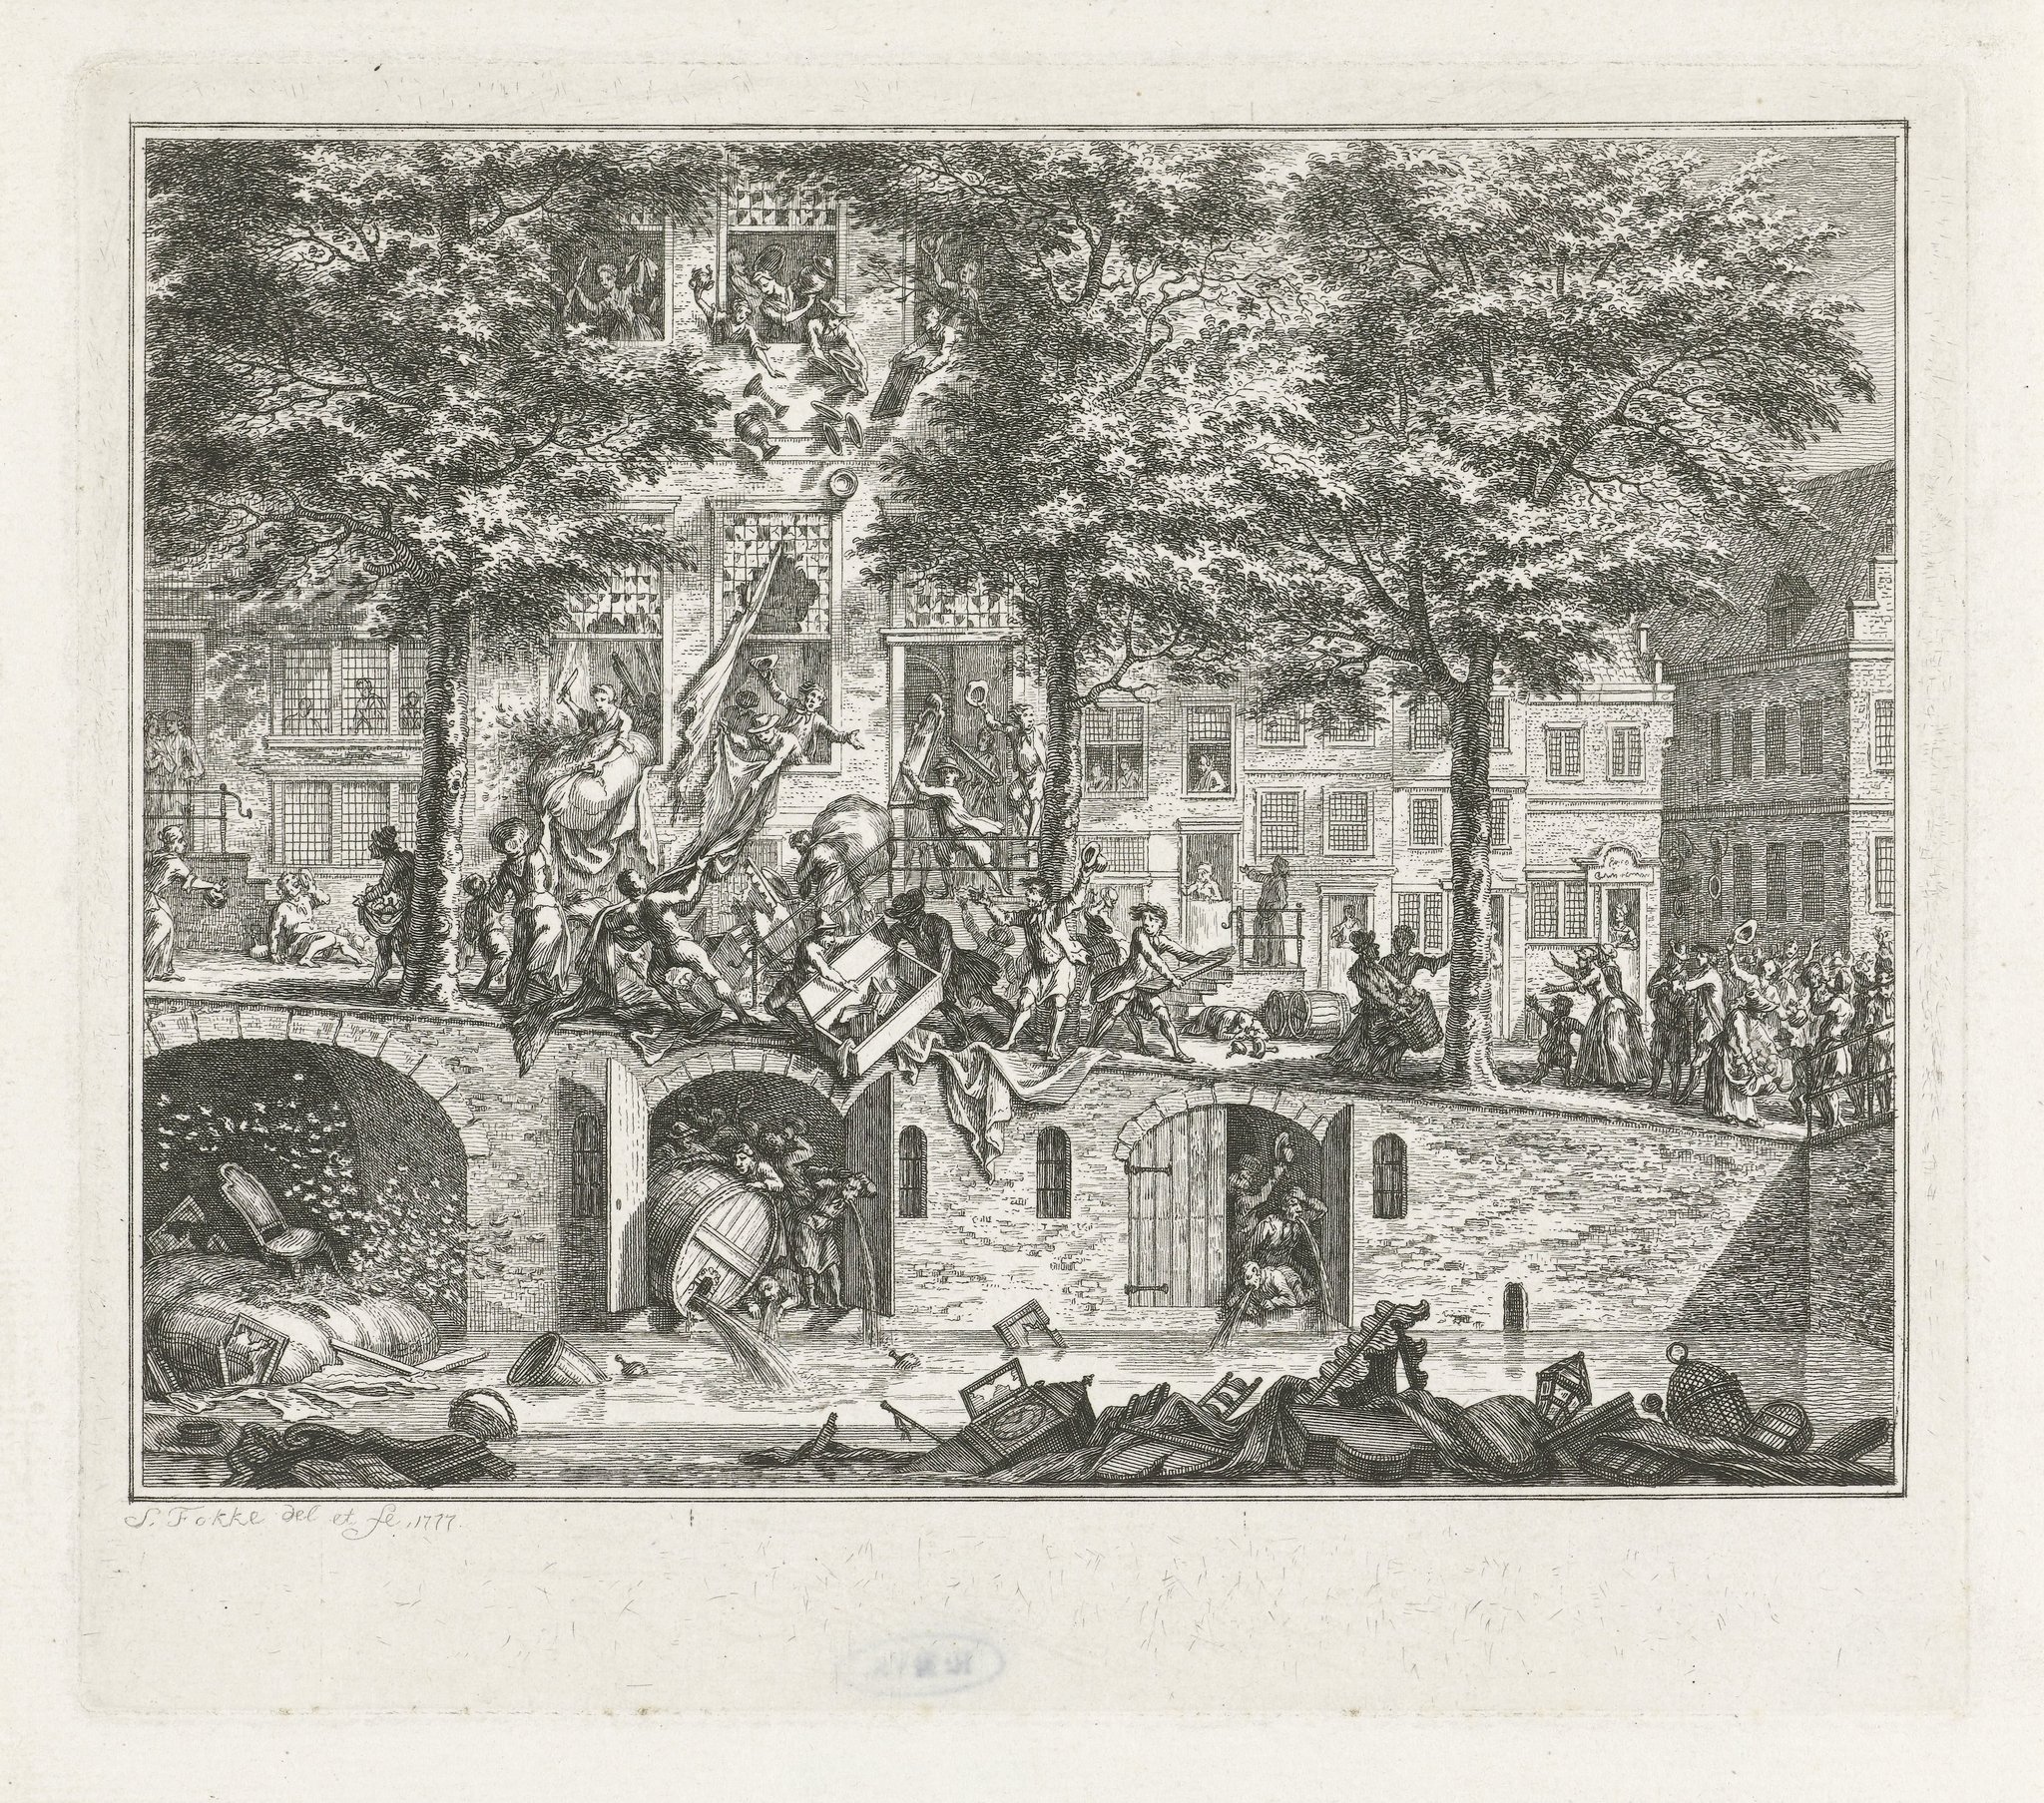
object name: history print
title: Plundering van het huis van A.M. van Arssen te Amsterdam, 1748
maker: simon fokke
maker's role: draughtsman, print maker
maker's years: 1712-1784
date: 1777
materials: paper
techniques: etching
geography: northern netherlands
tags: plundering ~ riot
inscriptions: collector's mark: Lugt 2228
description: Gebruikt als illustratie in: Jan Wagenaar, Vaderlandsche historie, vervattende de geschiedenissen der Vereenigde Nederlanden, inzonderheid die van Holland (...). Twintigste deel, beginnende met (...) den veldtogt (...) in't jaar 1745; en eindigende met de dood van (...) Willem Karel Henrik Friso (...) in't jaar 1751. Amsterdam: P. Schouten, 1782.